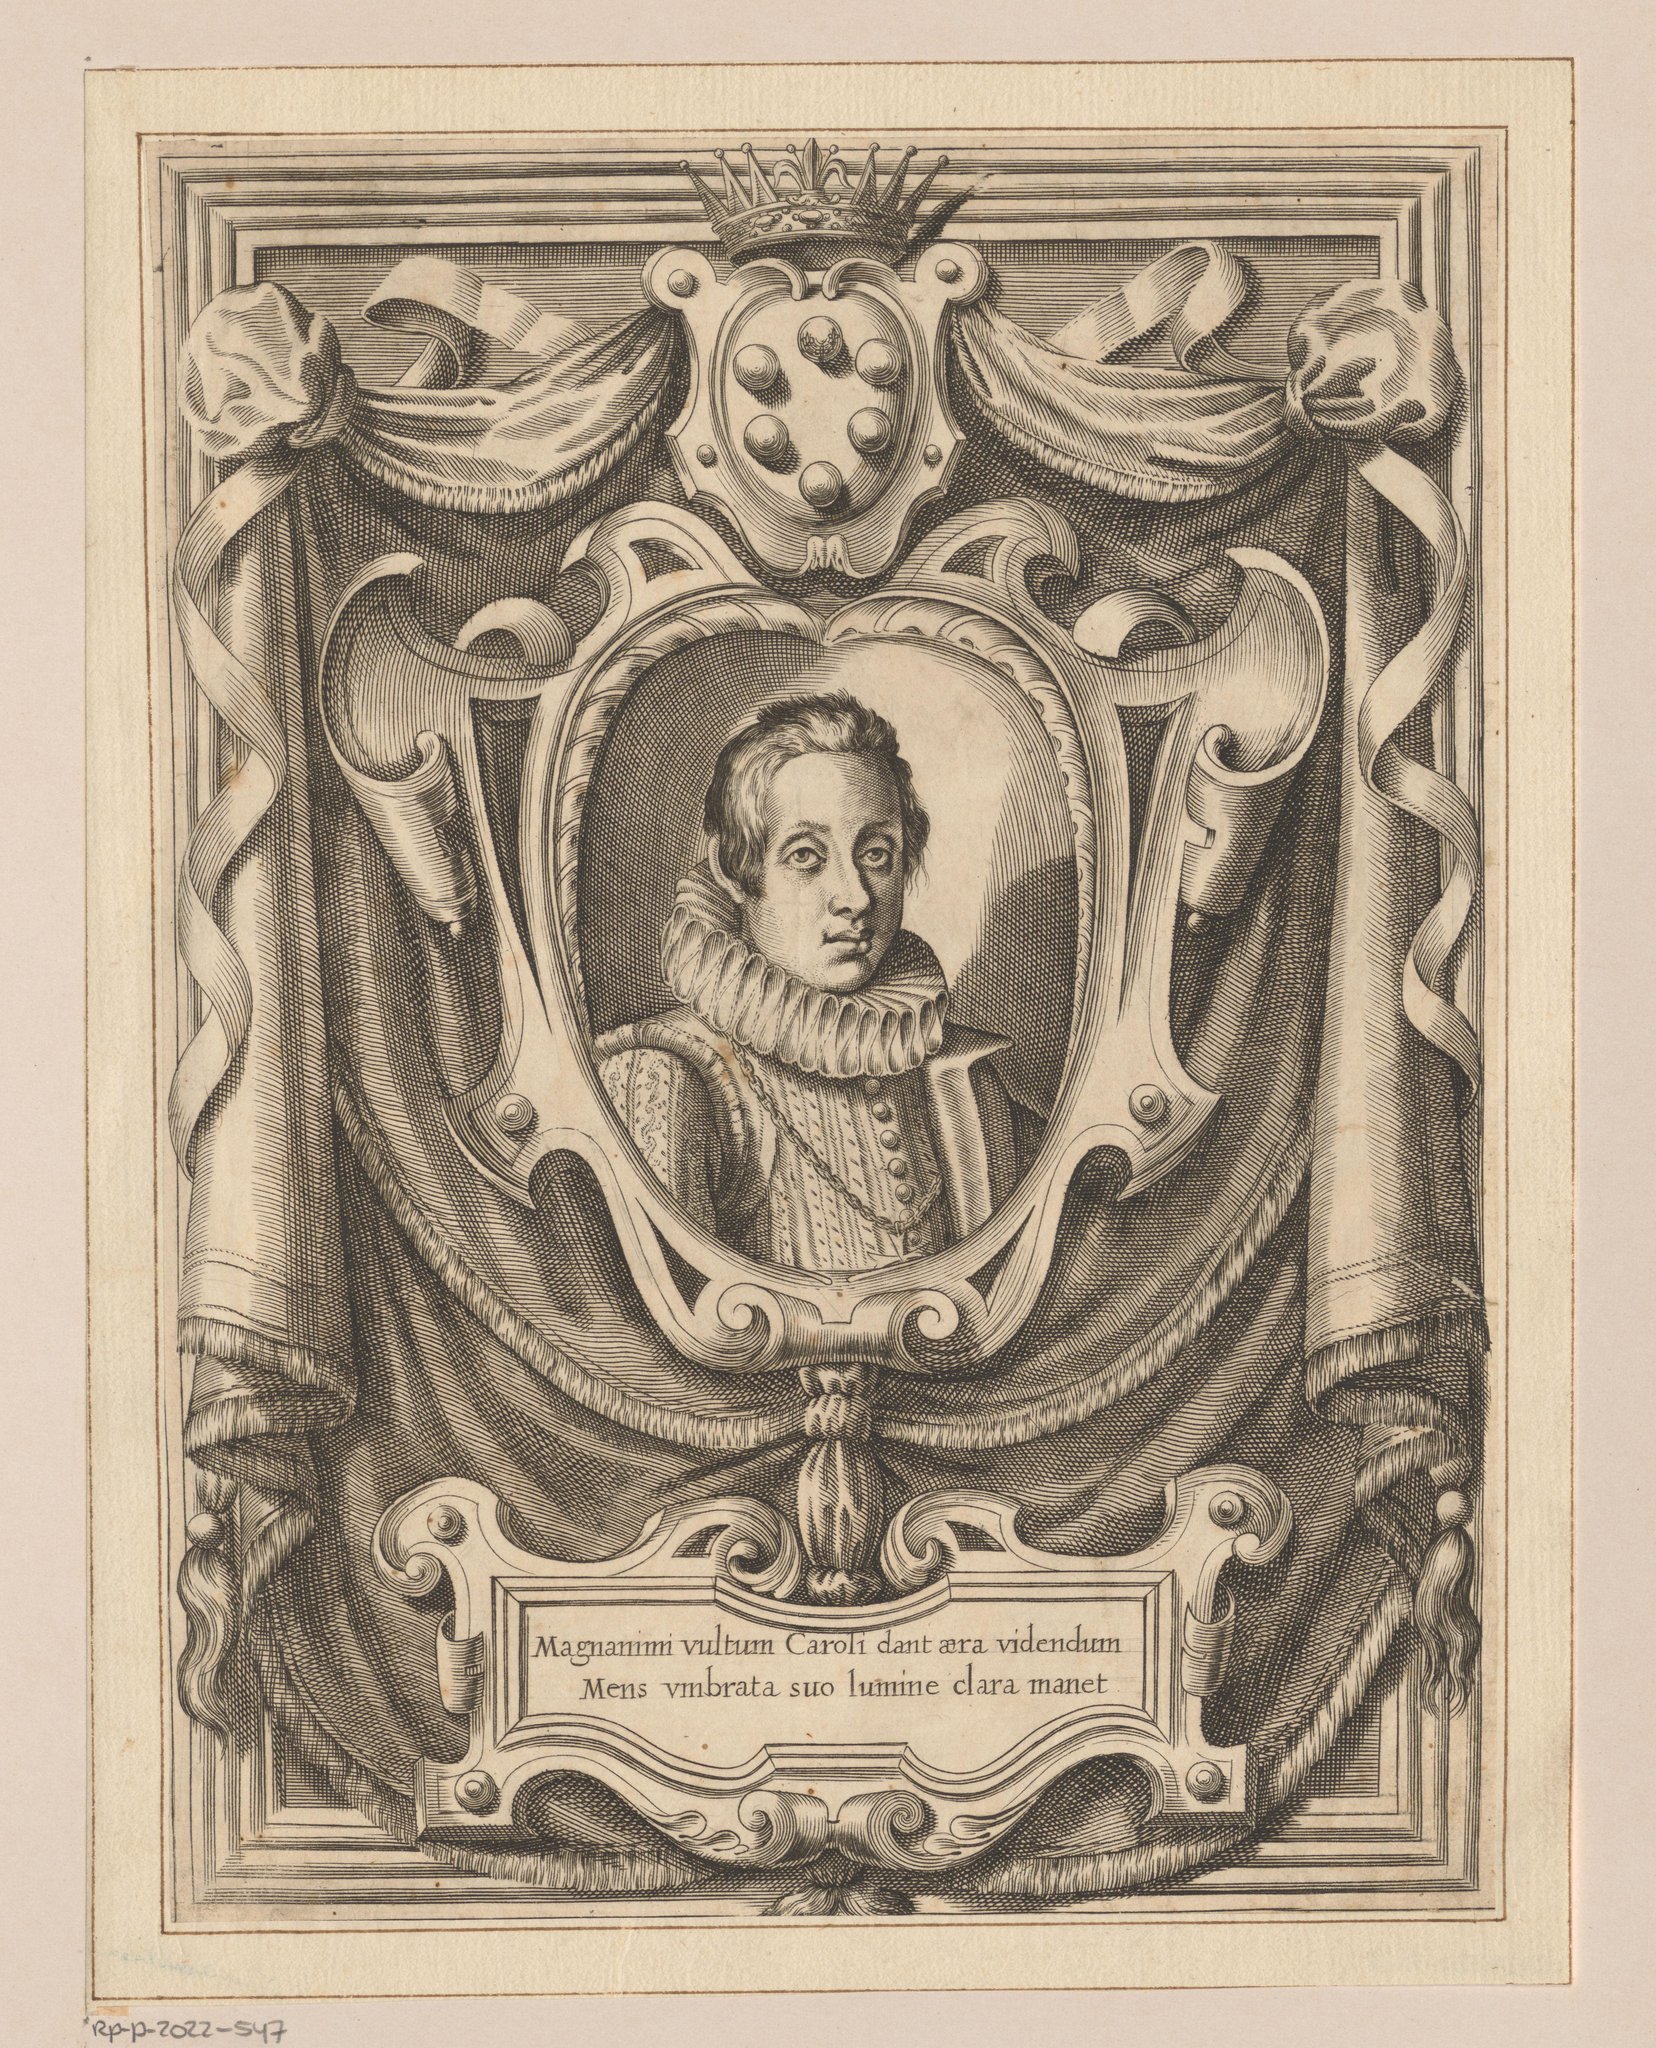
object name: print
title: Magnanimi vultum Caroli dant aera videndu Mens umbrata suo lumine clara manet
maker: Anonymous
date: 1600-1750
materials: paper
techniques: engraving, snipping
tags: cardinal, historical persons